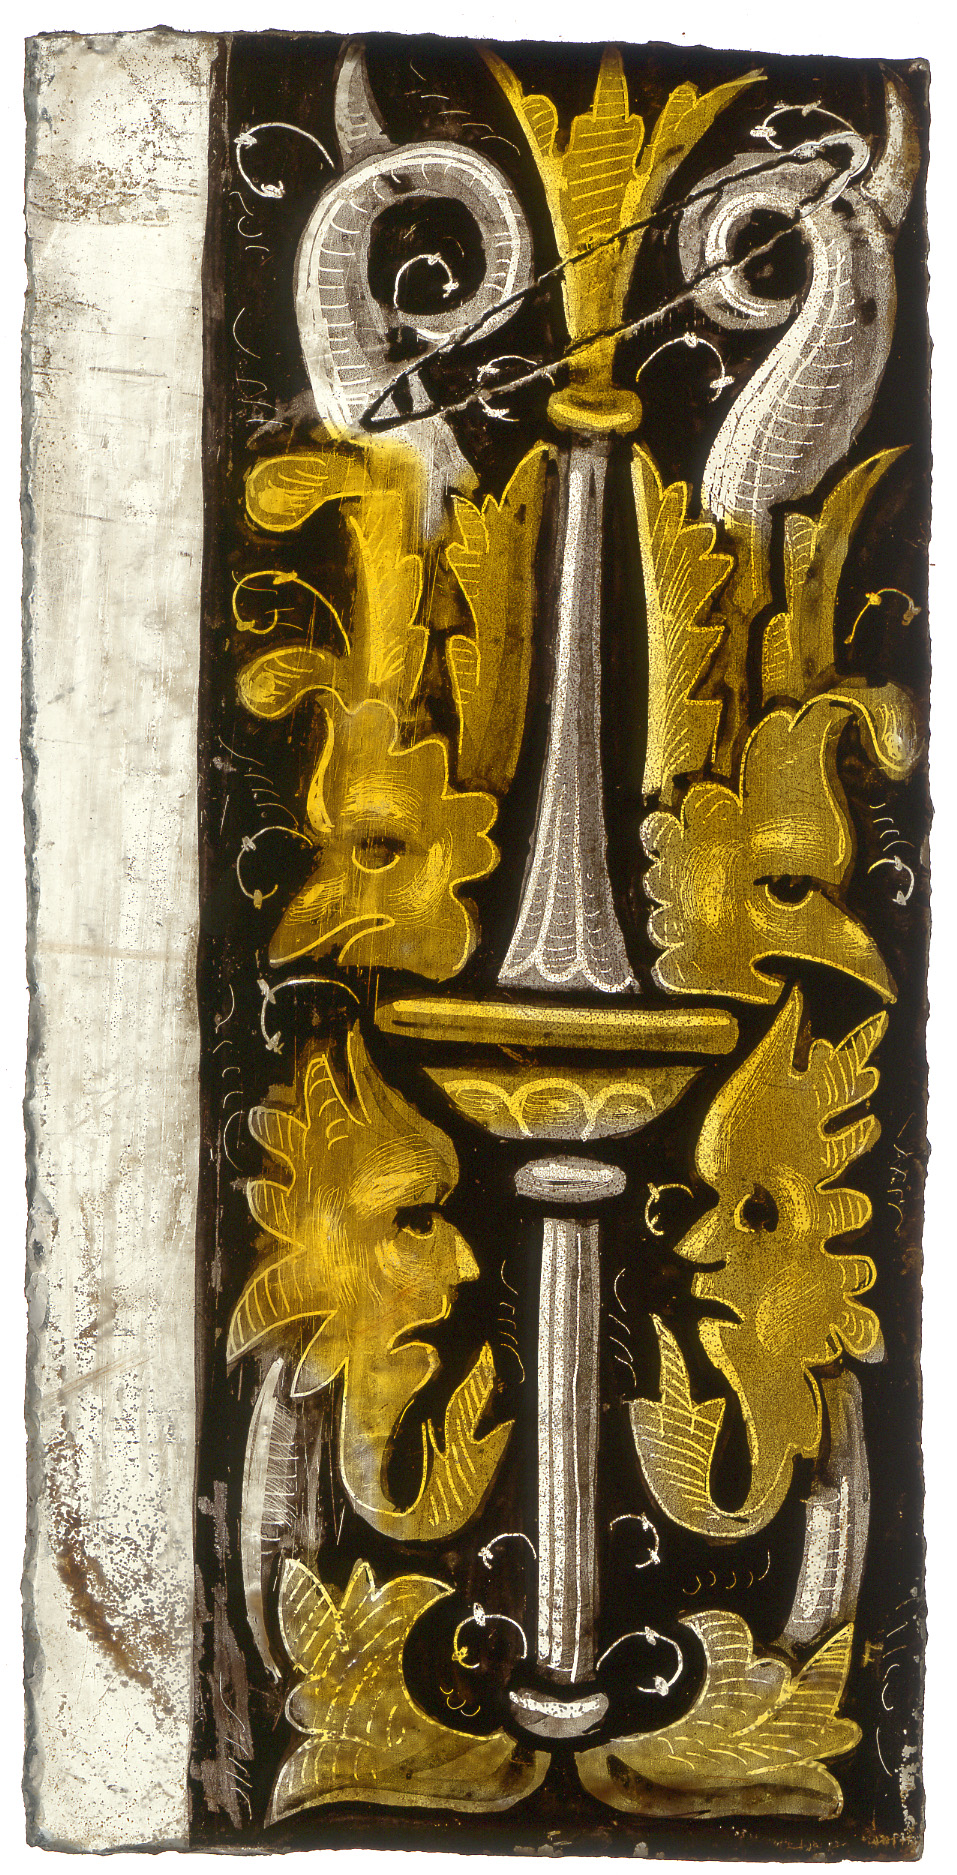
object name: border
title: Border fragment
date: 1501-1600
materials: glass, paint, pigment